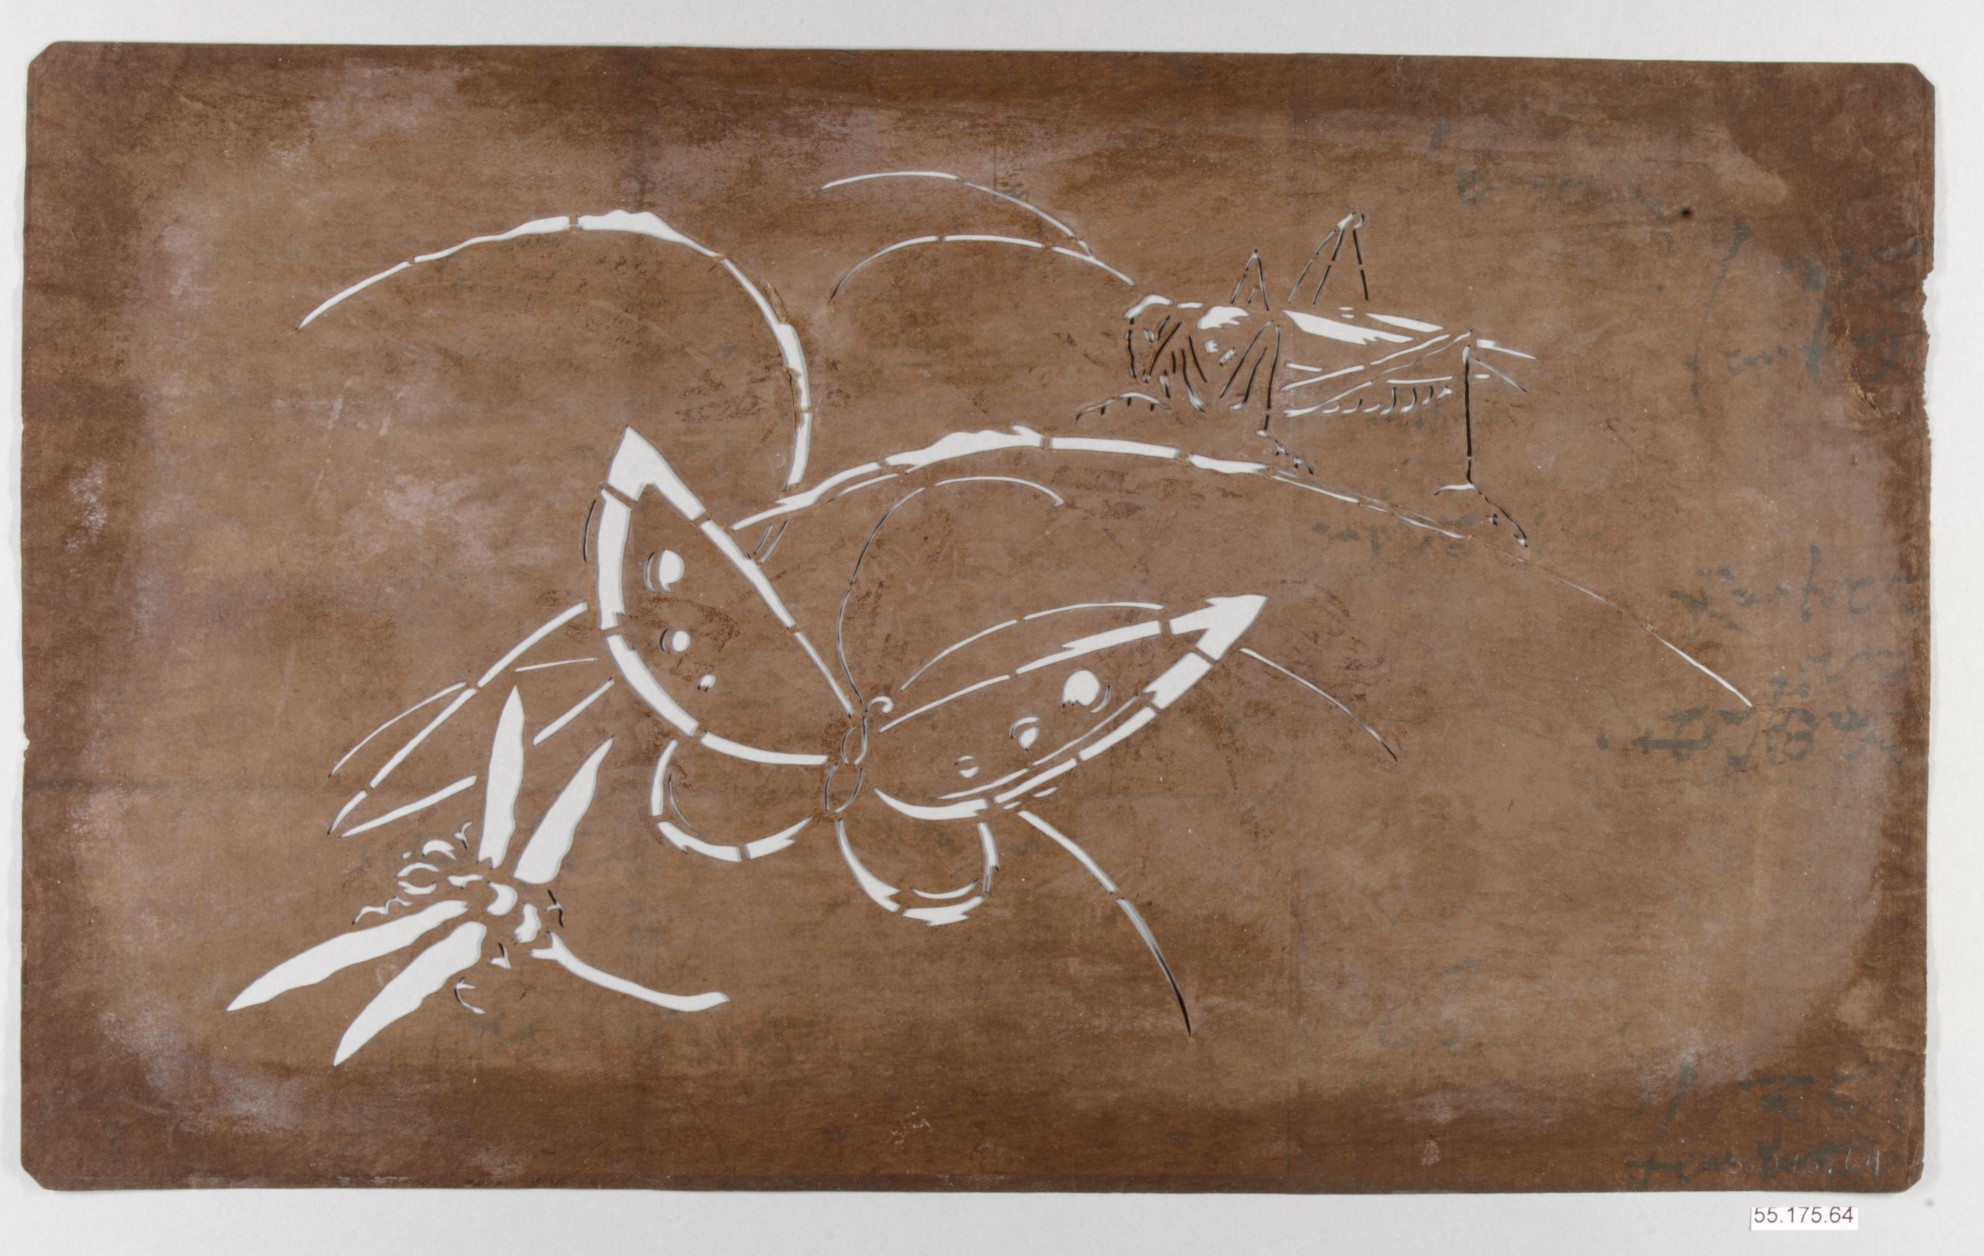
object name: stencil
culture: japanese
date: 1801-1900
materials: paper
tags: butterflies,dragonflies